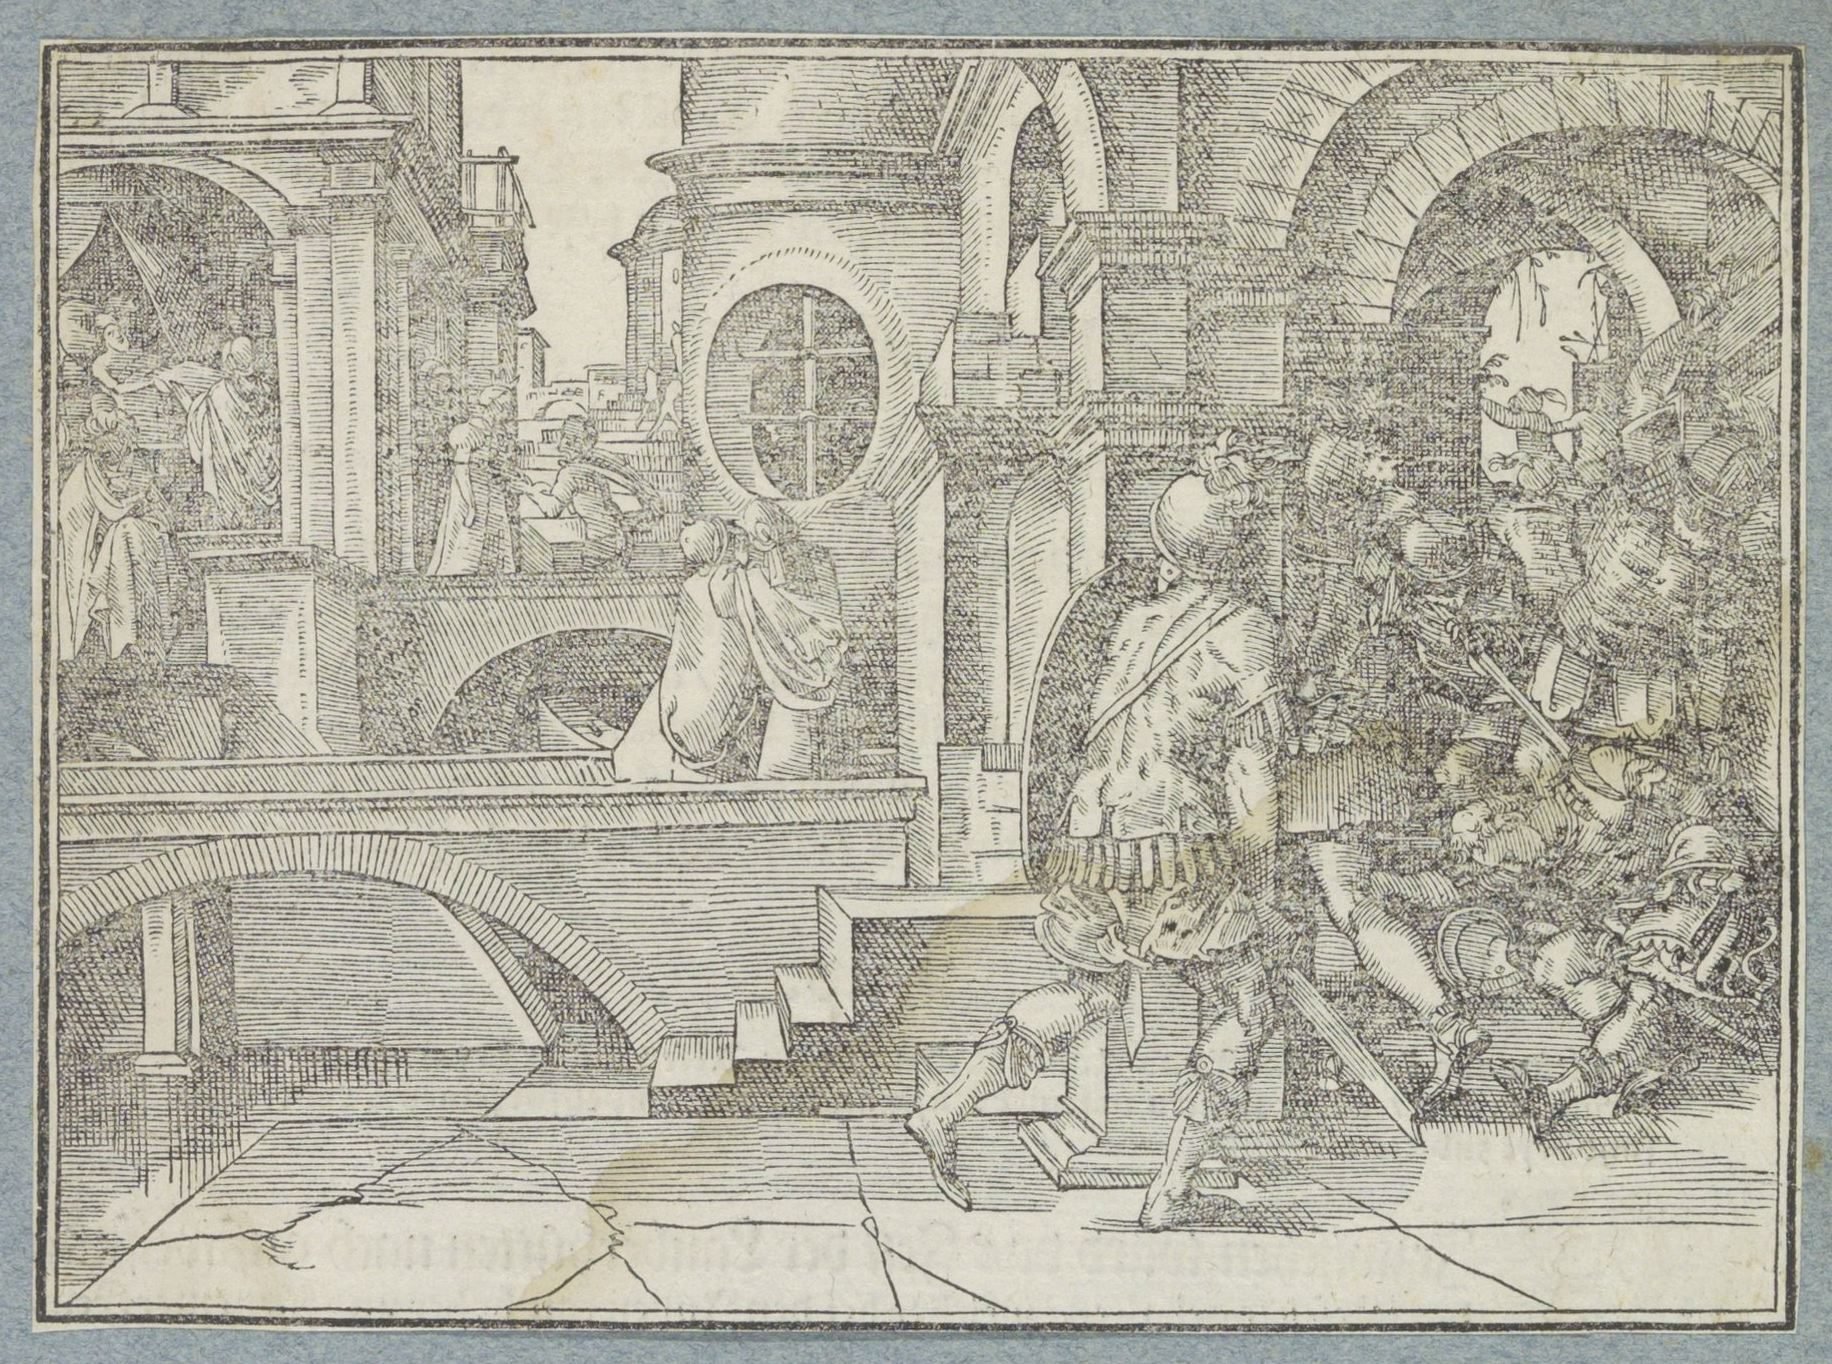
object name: album leaf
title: Antigonus in een gewelf vermoord door de lijfwacht van zijn broer Aristobulus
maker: christoffel van sichem (i)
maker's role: print maker, publisher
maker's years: 1546-1624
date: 1574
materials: paper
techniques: letterpress printing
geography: amsterdam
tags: deathbed, attempt, political murder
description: In een gewelf wordt Antigonus, zoon van Hyrkanus, door de lijfwacht van zijn broer en koning Aristobulus gedood. De lijfwacht had het vermoeden dat Antigonus een aanslag op Aristobulus beraamde. Aristobulus was zeer aangeslagen door het bericht van de dood van zijn broer, werd ziek en overleed. De prent maakt deel uit van een album.